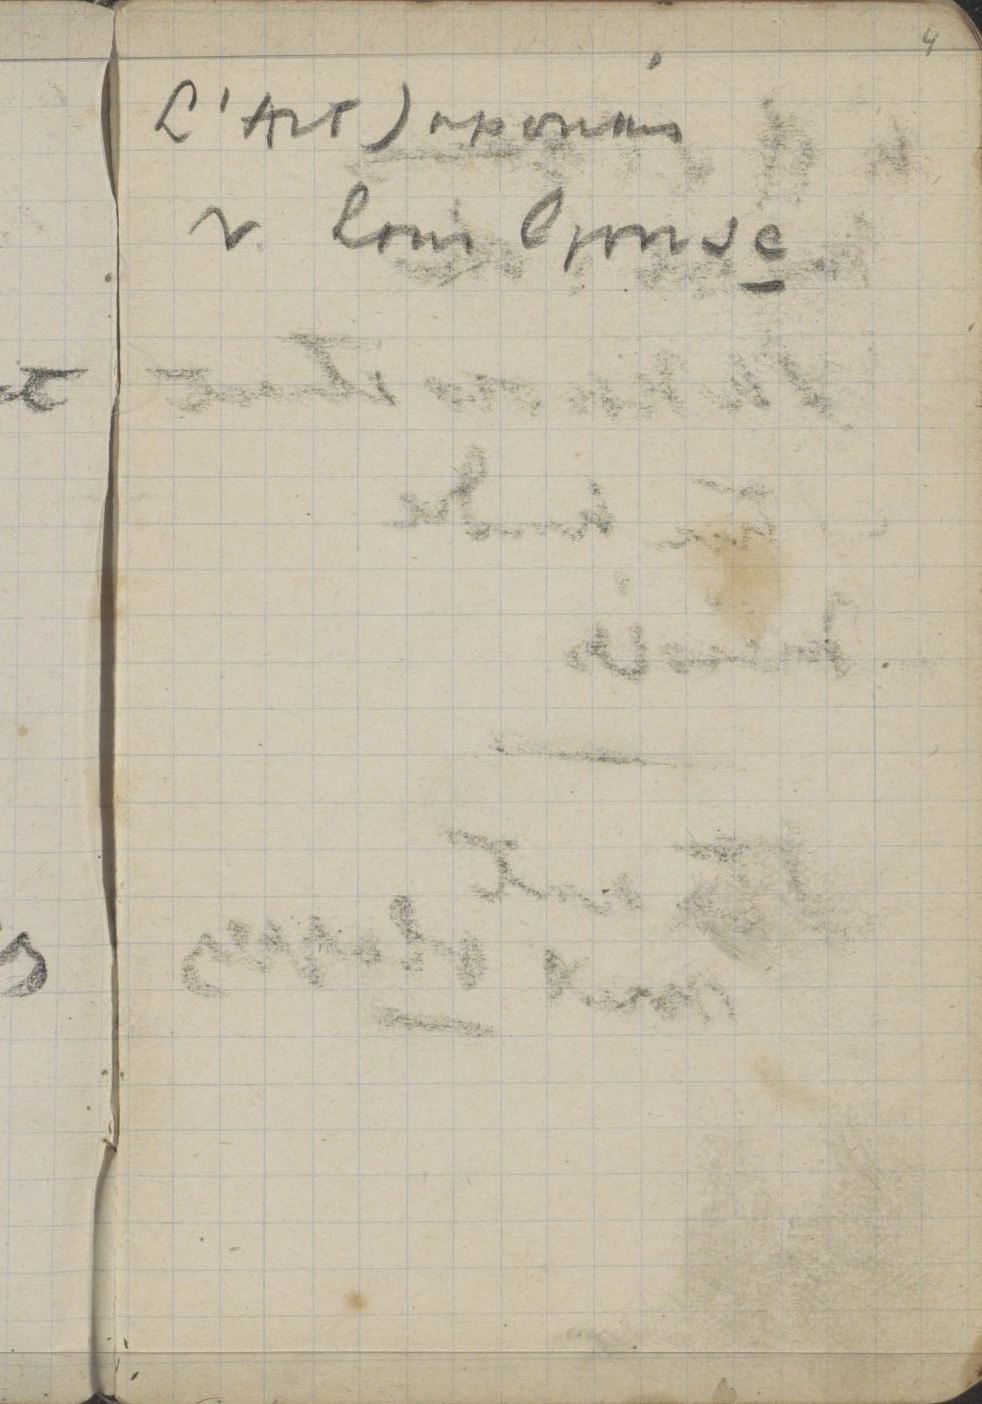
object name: sketchbook leaf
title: Annotaties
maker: george hendrik breitner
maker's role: draughtsman, painter, print maker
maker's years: 1857-1923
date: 1893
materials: chalk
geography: amsterdam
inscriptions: annotation: ‘L'Art Japonais/ v. Louis Gonse’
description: Annotaties. Pagina 4 uit een schetsboek met 30 bladen vervaardigd in Amsterdam.